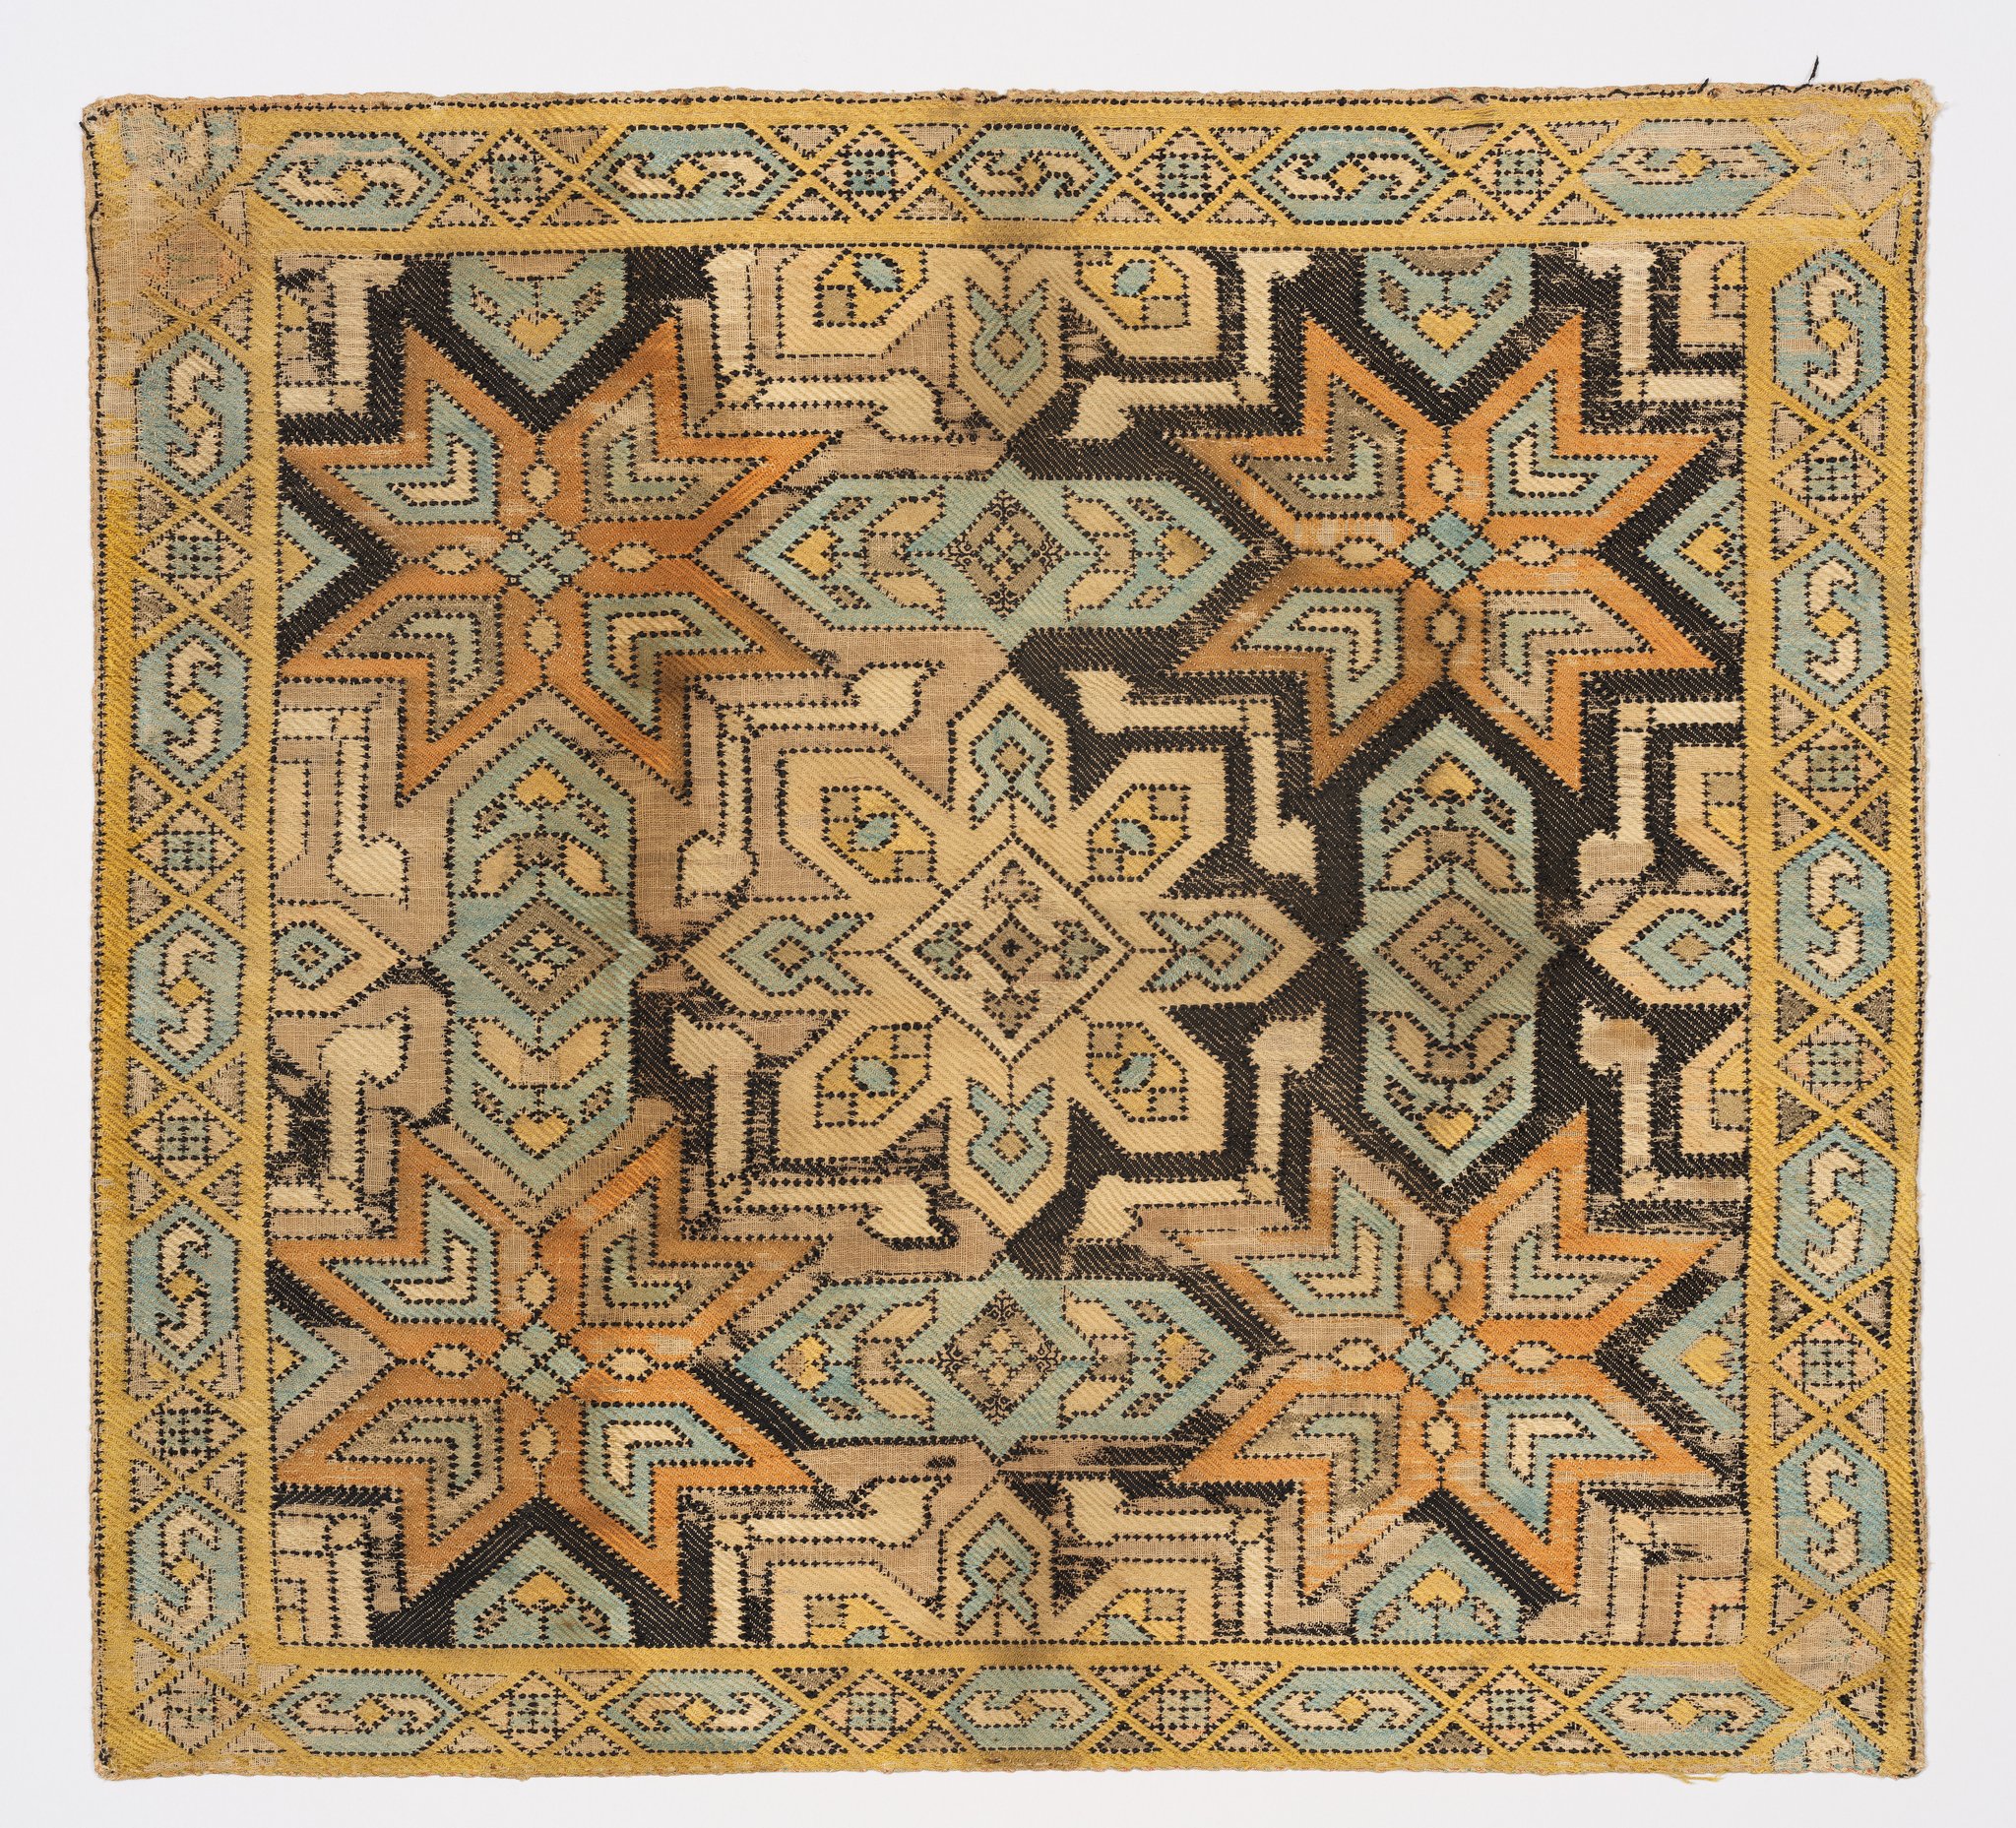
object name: cover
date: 1701-1800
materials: linen, silk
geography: caucasus